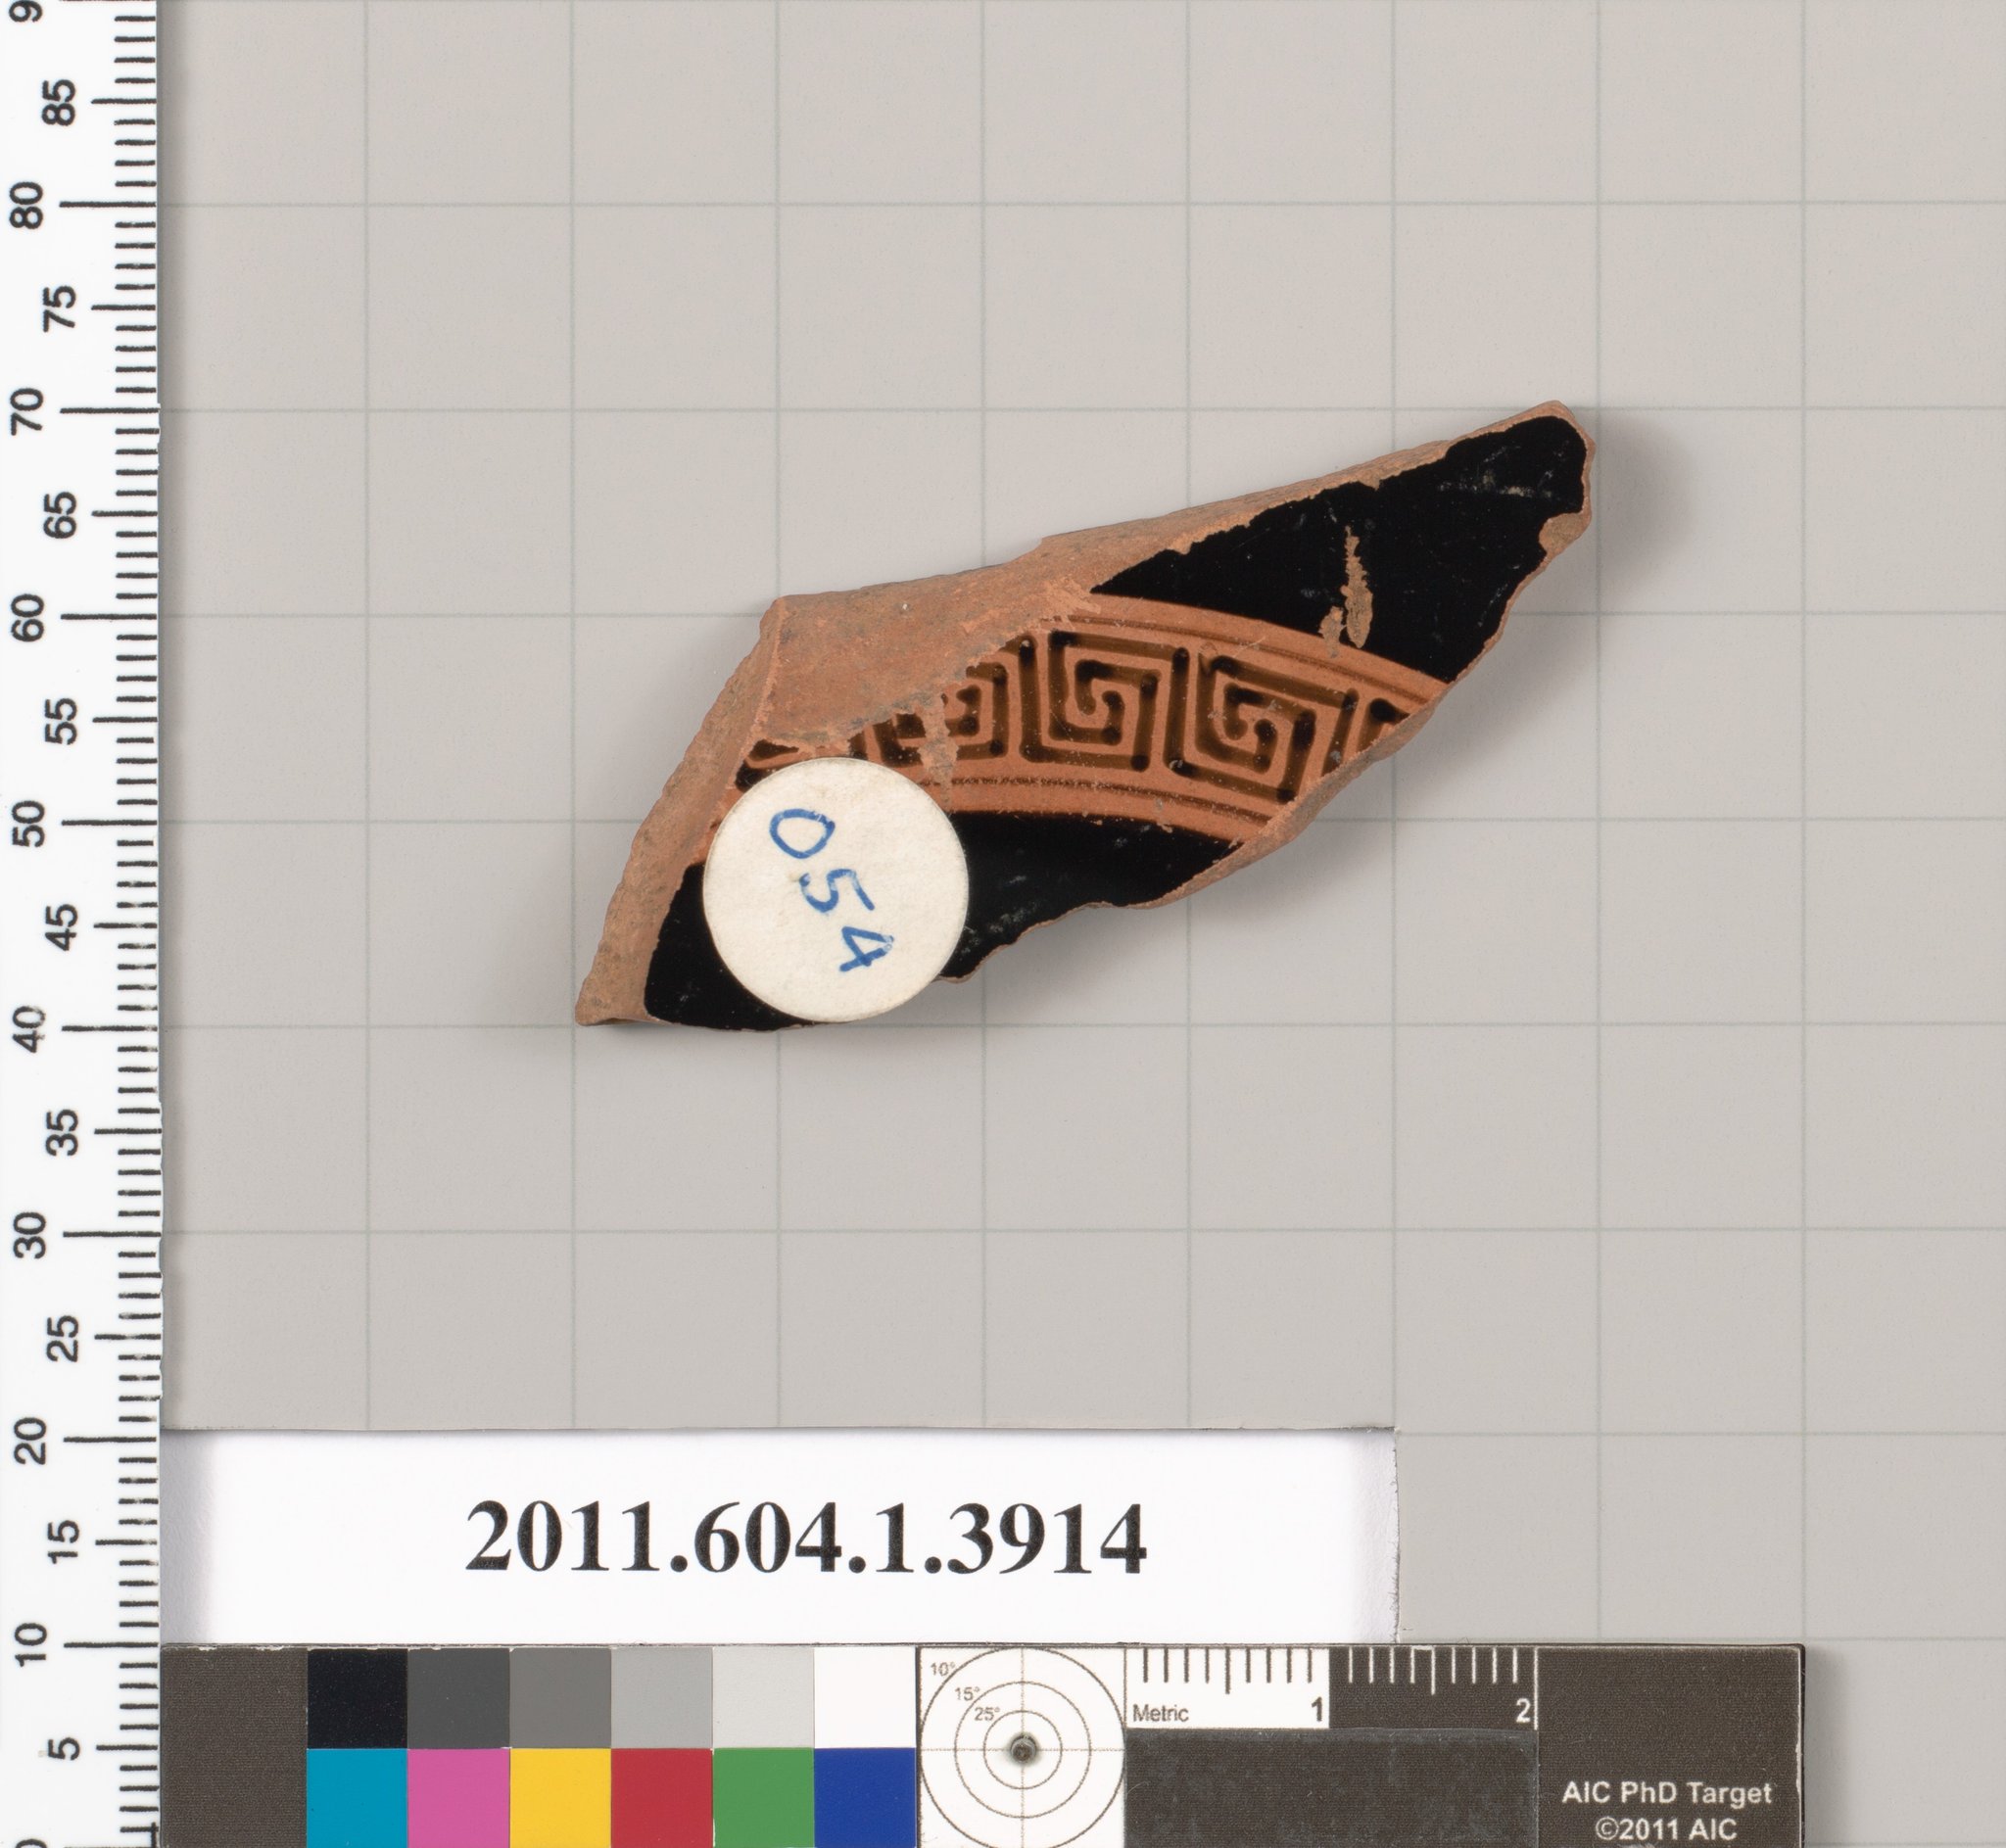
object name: kylix fragment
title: Terracotta fragment of a kylix (drinking cup)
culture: greek, attic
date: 475-451 BCE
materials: terracotta